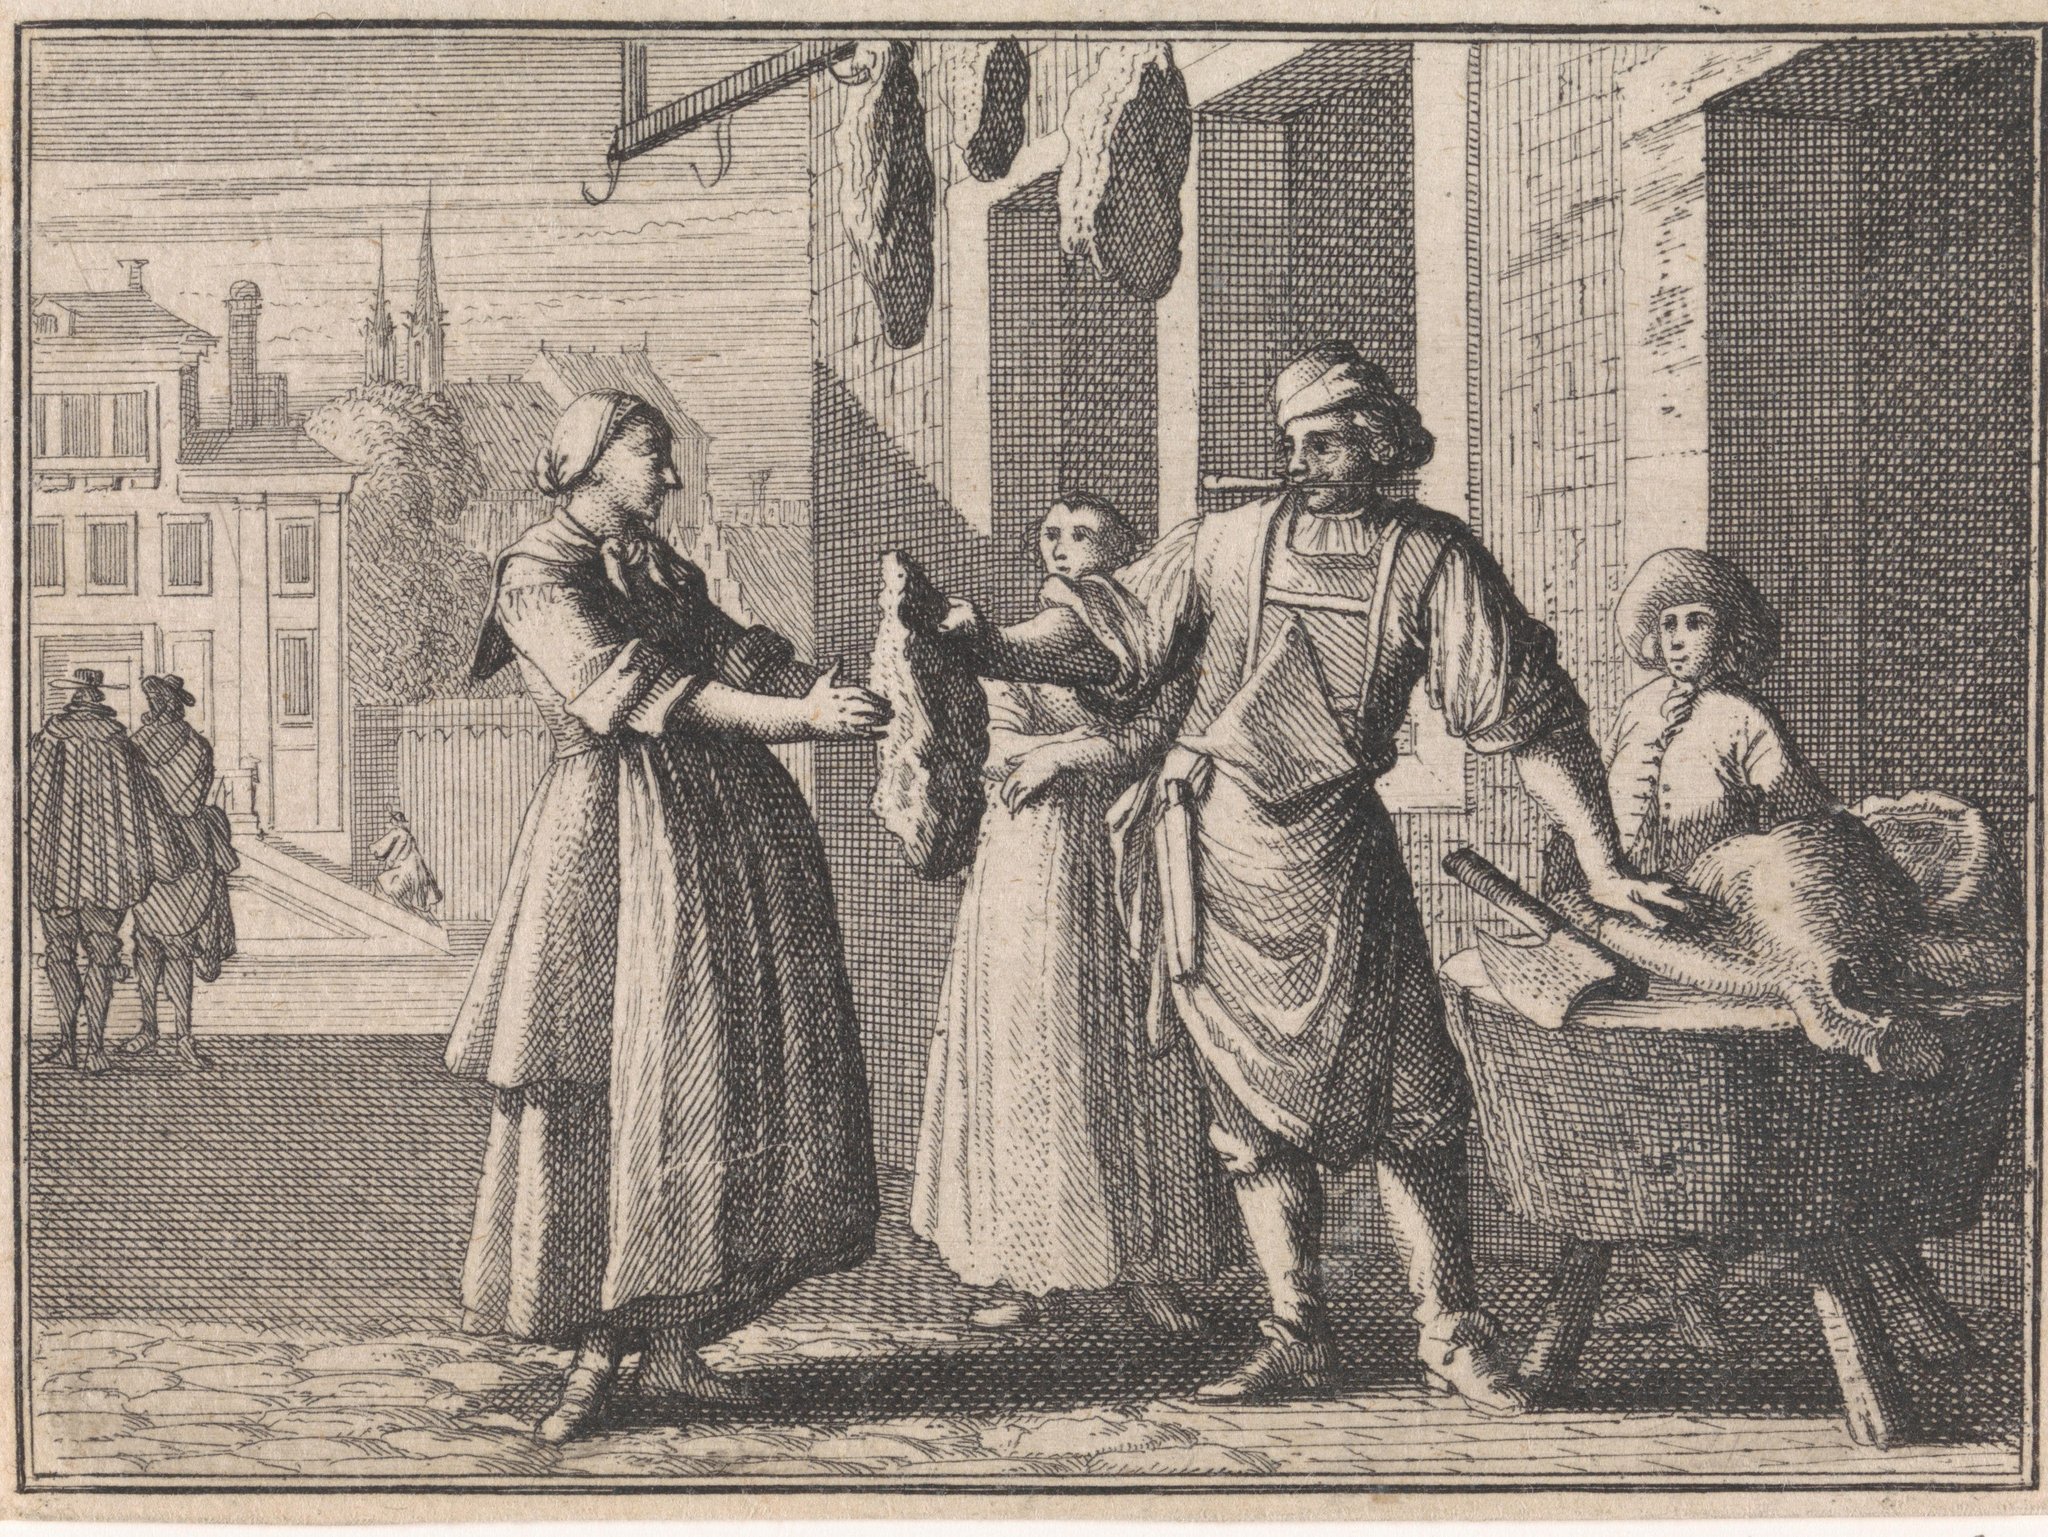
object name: book illustration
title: Hui Sau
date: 1710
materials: paper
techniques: etching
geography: nuremberg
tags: meat; still life of meat, pregnant woman, pregnancy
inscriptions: collector's mark: Lugt 240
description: Illustratie uit: Abraham a Sancta Clara. Heilsames Gemisch Gemasch, das ist: Allerley seltsame und verwunderliche Geschichten (...). Neurenberg: Christoph Weigel, 1710, p. 221.